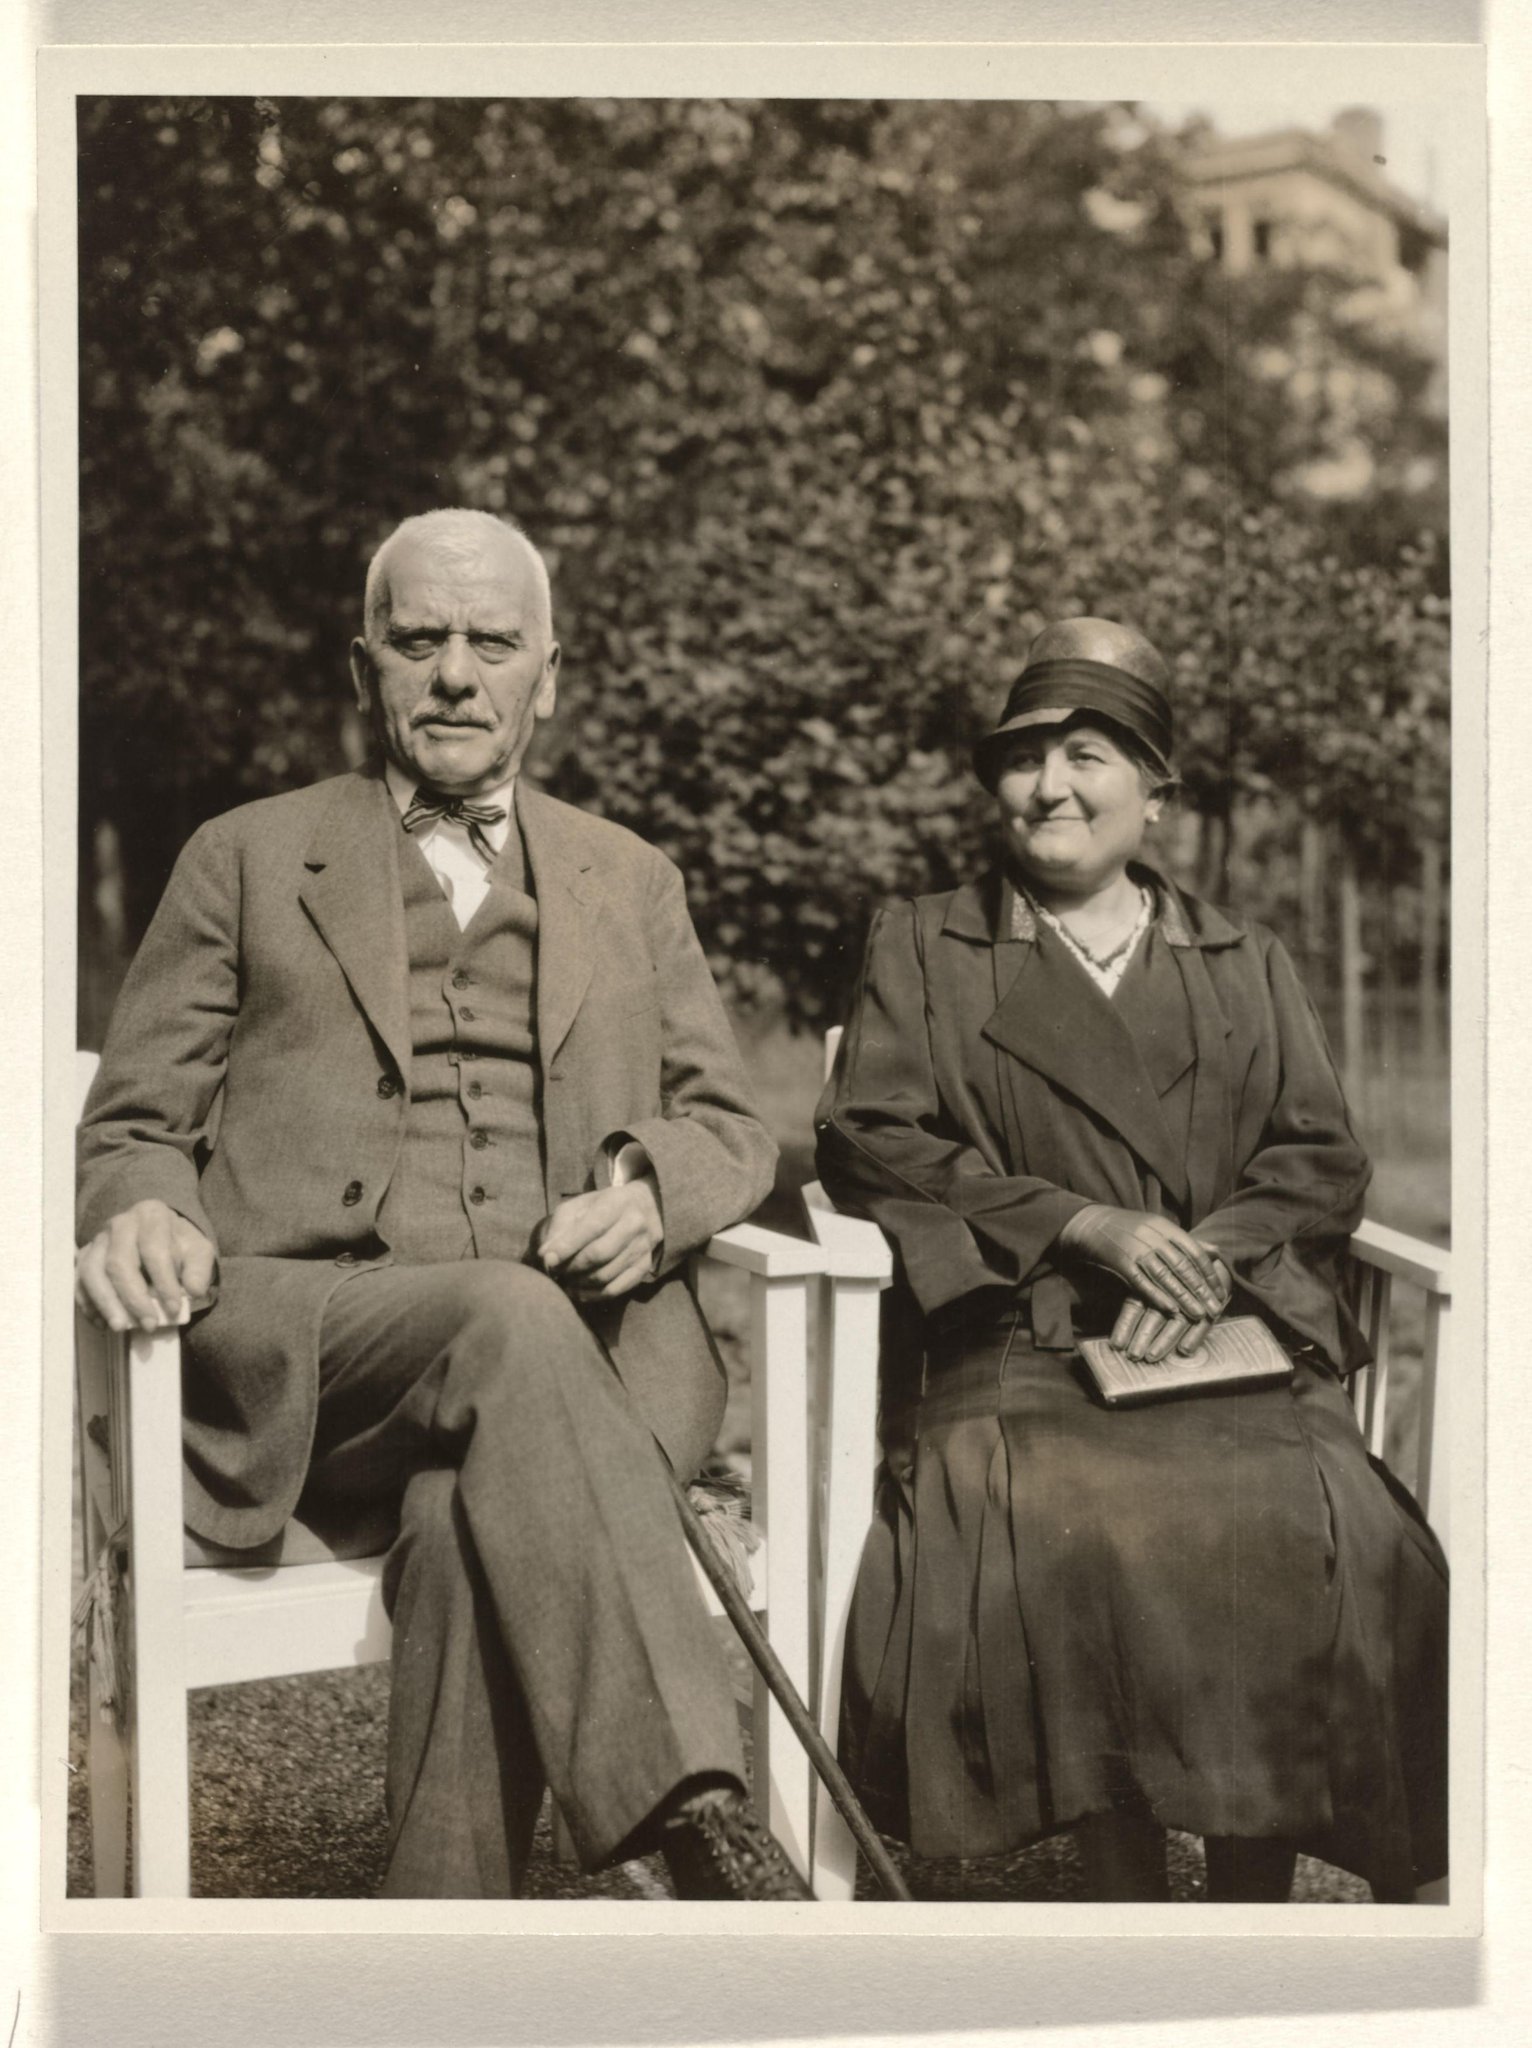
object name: photograph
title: Meir Wachenheimer met stok in zijn handen en zijn echtgenote Mathilde Wertheimer-Wachenheimer met haar handen gevouwen over een portefeuille op haar schoot, gezeten op stoelen in een tuin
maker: Anonymous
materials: photographic support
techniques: gelatin silver print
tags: meir wachenheimer, sobibór, mathilde wachenheimer-wertheimer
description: Meir Wachenheimer met stok in zijn handen (links) en zijn echtgenote Mathilde Wertheimer-Wachenheimer (rechts) met haar handen gevouwen over een portefeuille op haar schoot, gezeten op stoelen in een tuin.